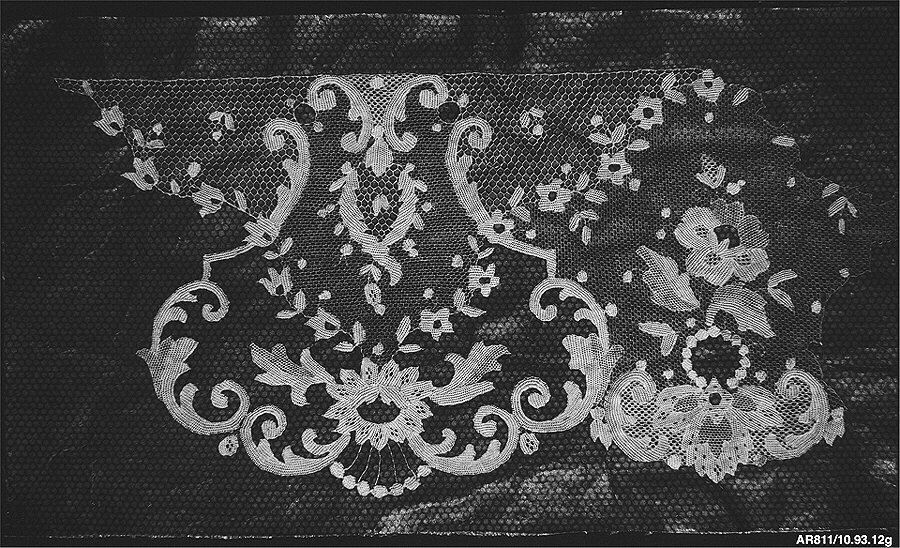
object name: sample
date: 1801-1900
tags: flowers